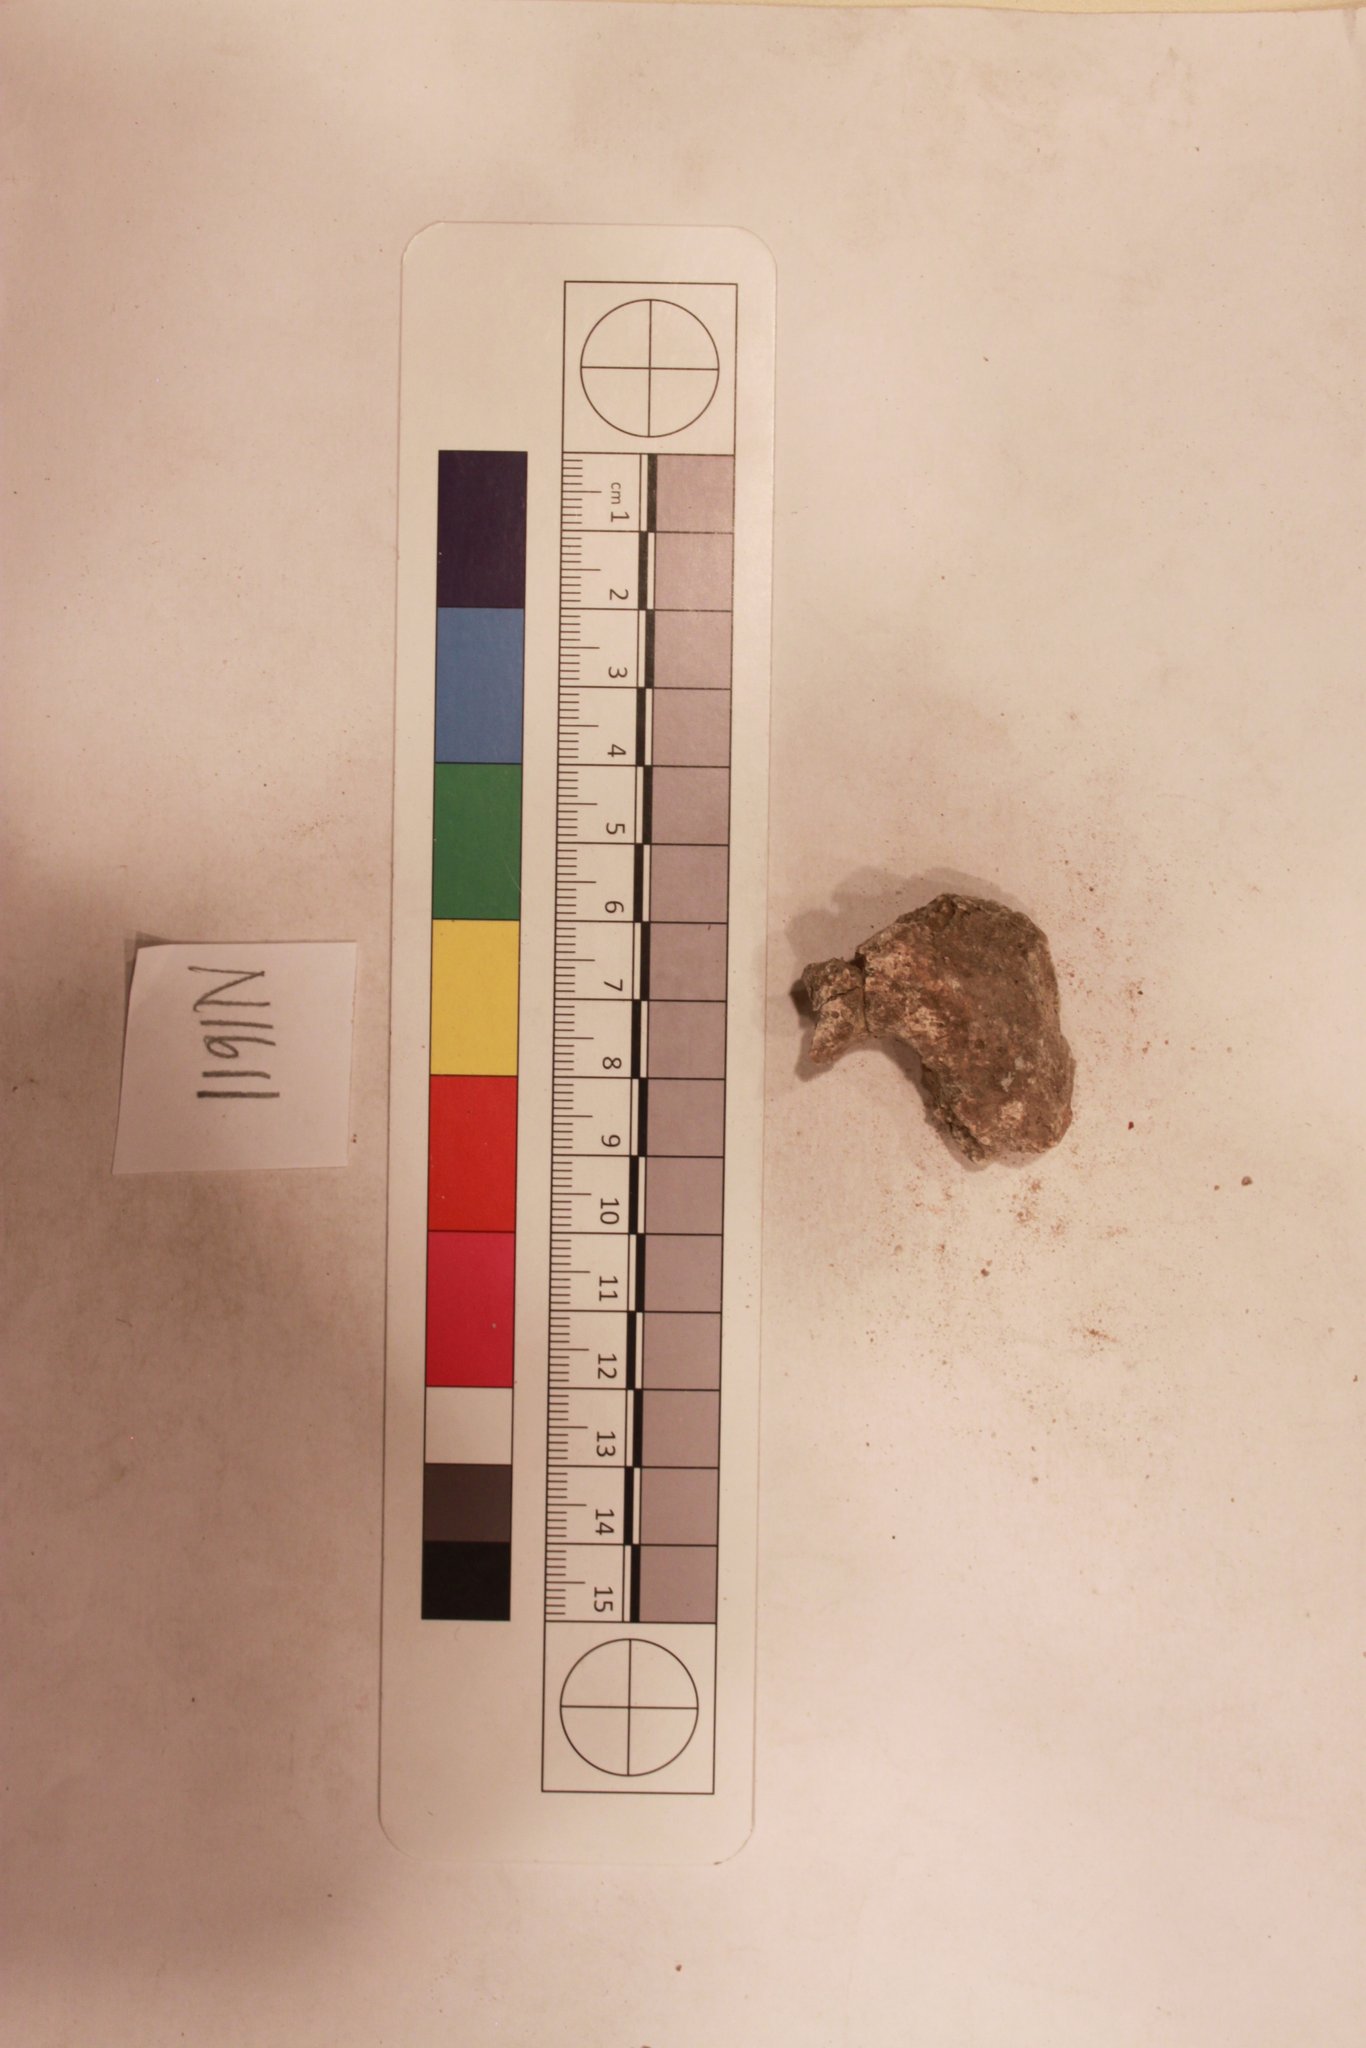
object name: fragment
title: Stucco Fragment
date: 701-1200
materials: plaster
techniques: carving, painting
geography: iran